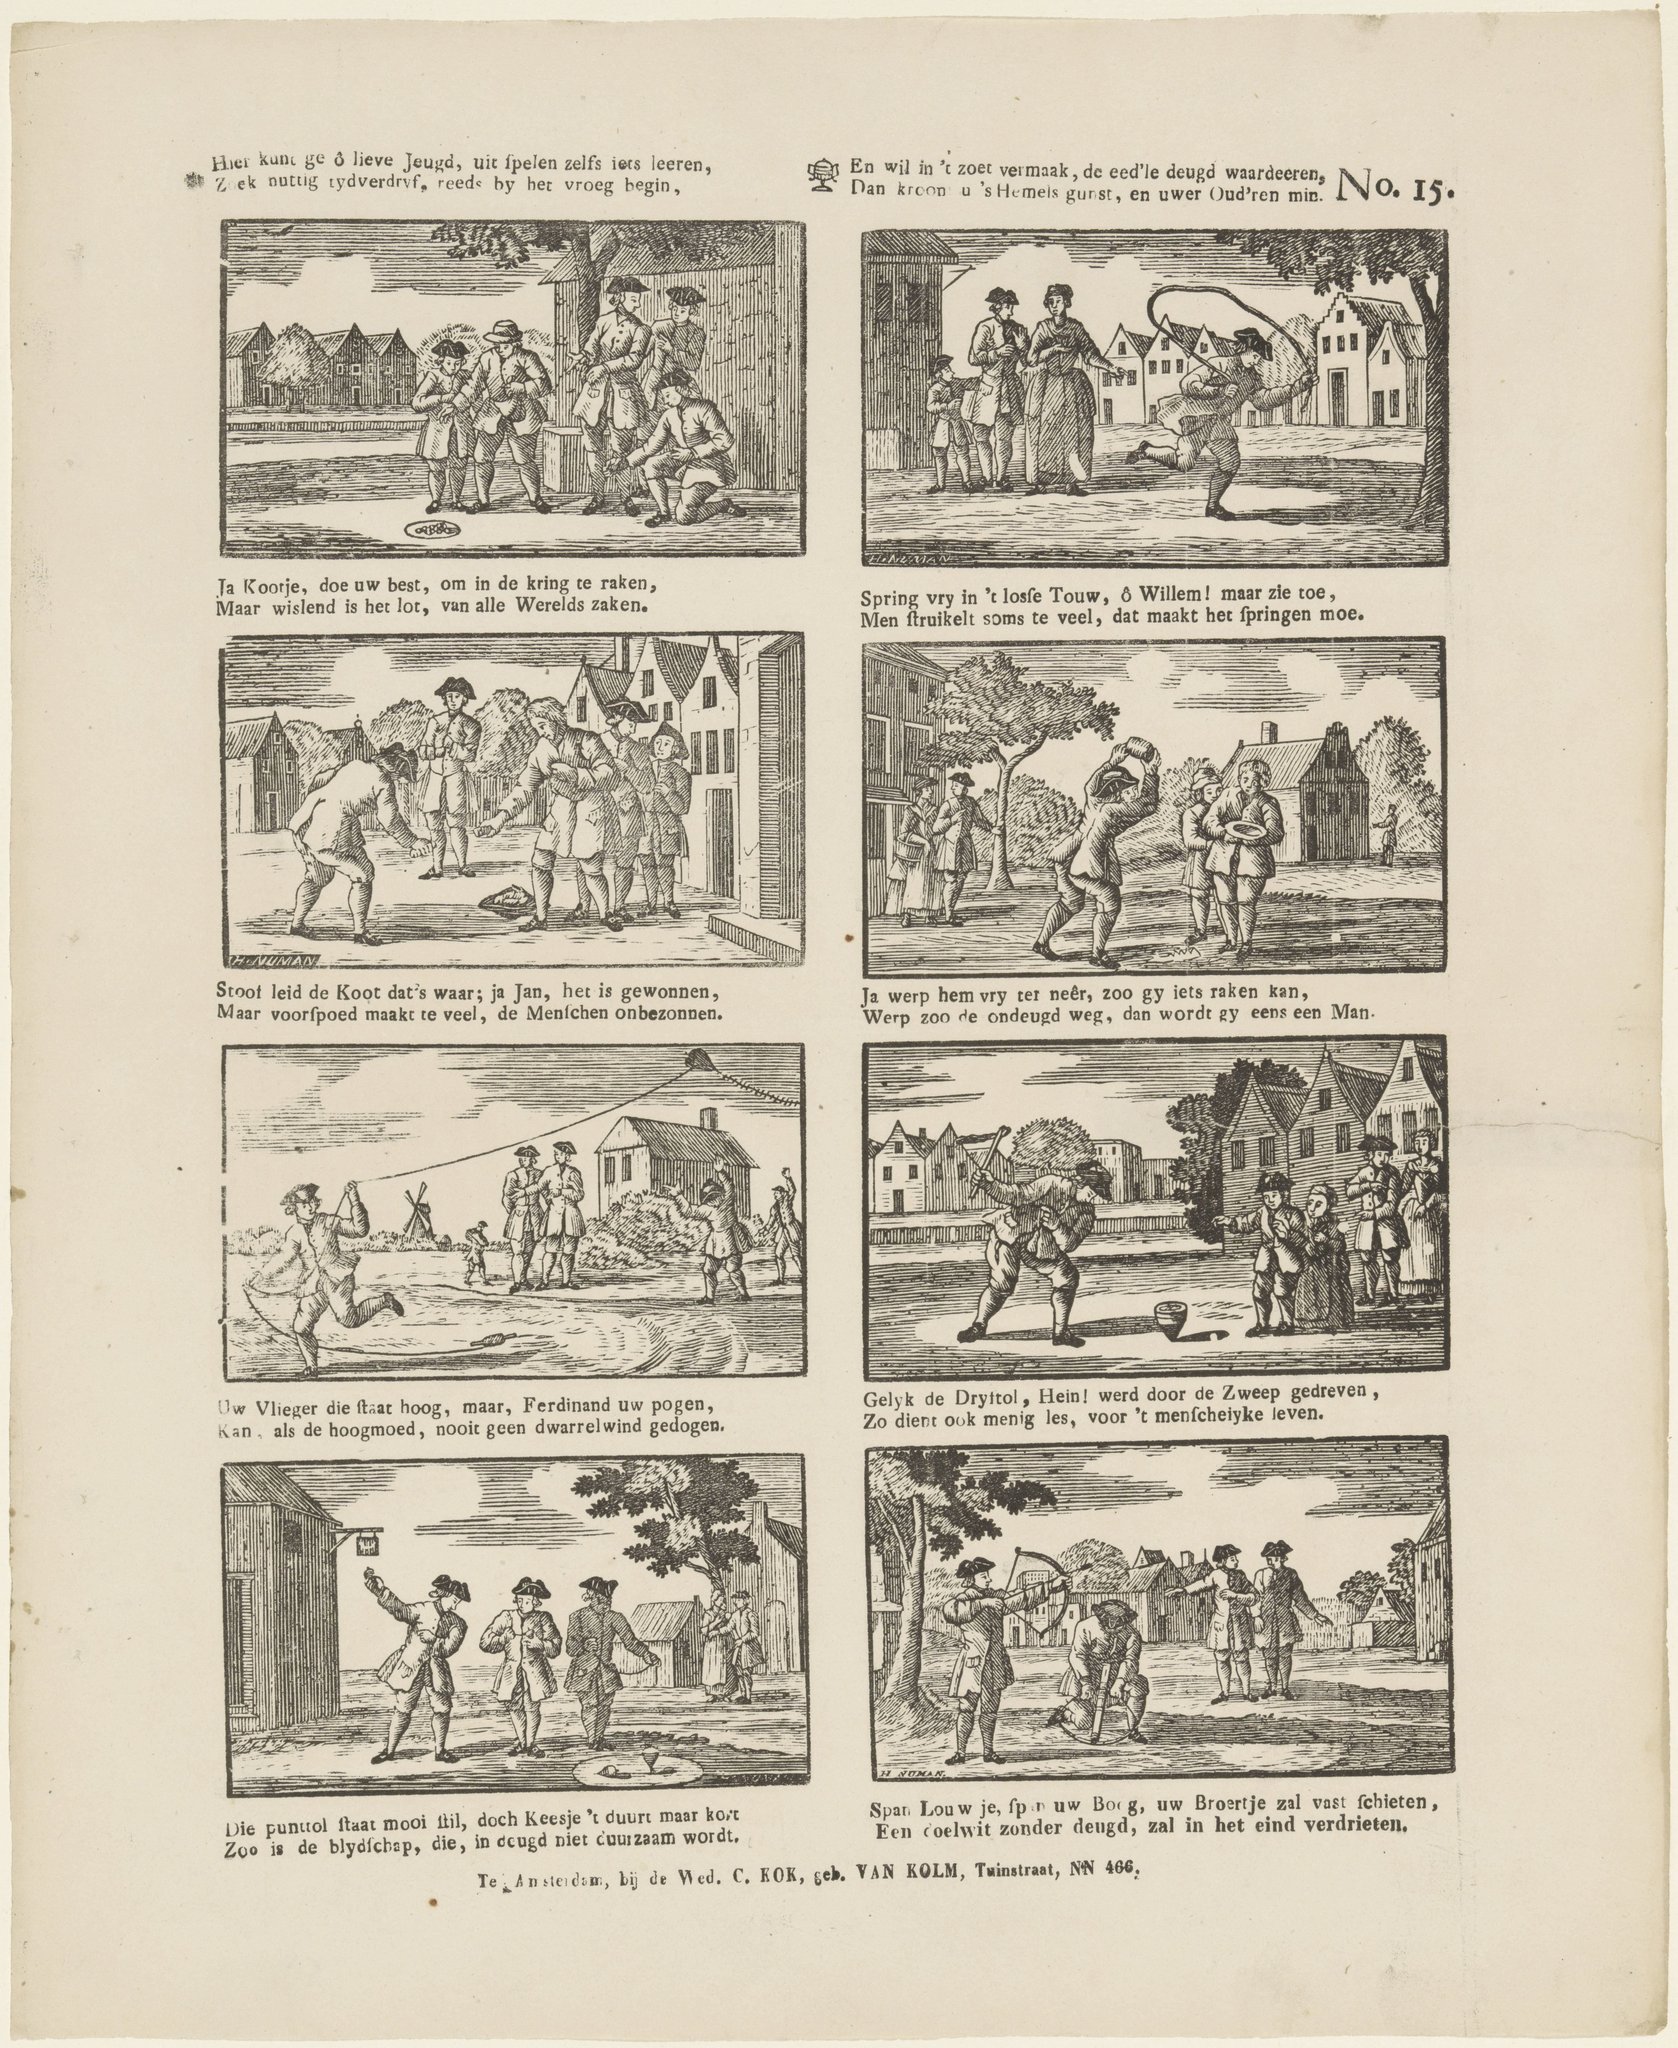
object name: print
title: Hier kunt ge ô lieve jeugd, uit spelen zelfs iets leeren, / zoek nuttig tydverdryf, reeds by het vroeg begin, / En wil in 't zoet vermaak, de eed'le deugd waardeeren, / Dan kroont u 's hemels gunst, en uwer oud'ren min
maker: weduwe c. kok geboren van kolm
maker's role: printer, publisher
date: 1842-1866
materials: paper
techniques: letterpress printing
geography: amsterdam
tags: children's games and plays, (flying a) kite, games using special objects (marbles, top, hoop, etc.), jumping-rope games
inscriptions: collector's mark: Lugt 2760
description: Blad met 8 voorstellingen van kinderspelen, waaronder touwtjespringen, vliegeren en tollen. Onder elke afbeelding een tweeregelig vers. Genummerd rechtsboven: No. 15.